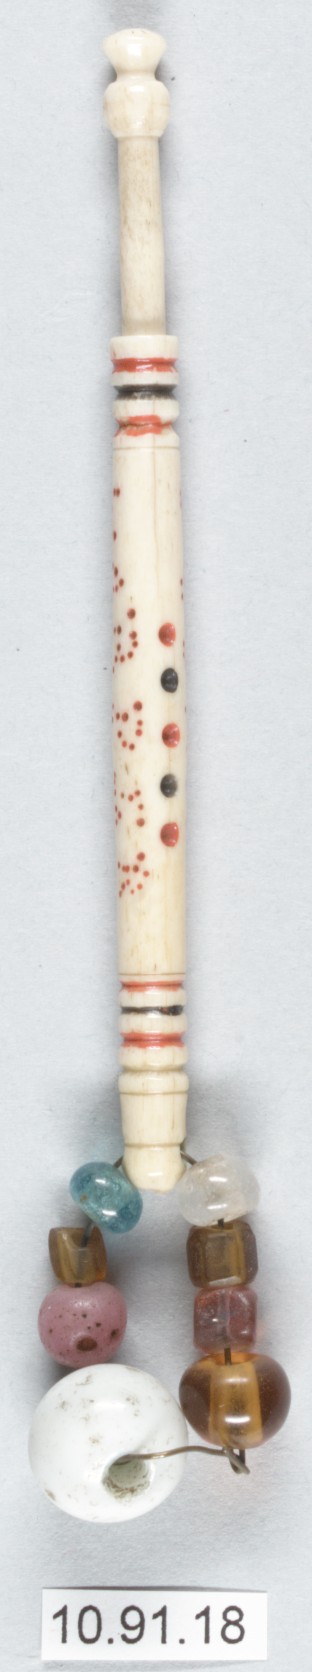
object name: bobbin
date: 1801-1900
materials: bone